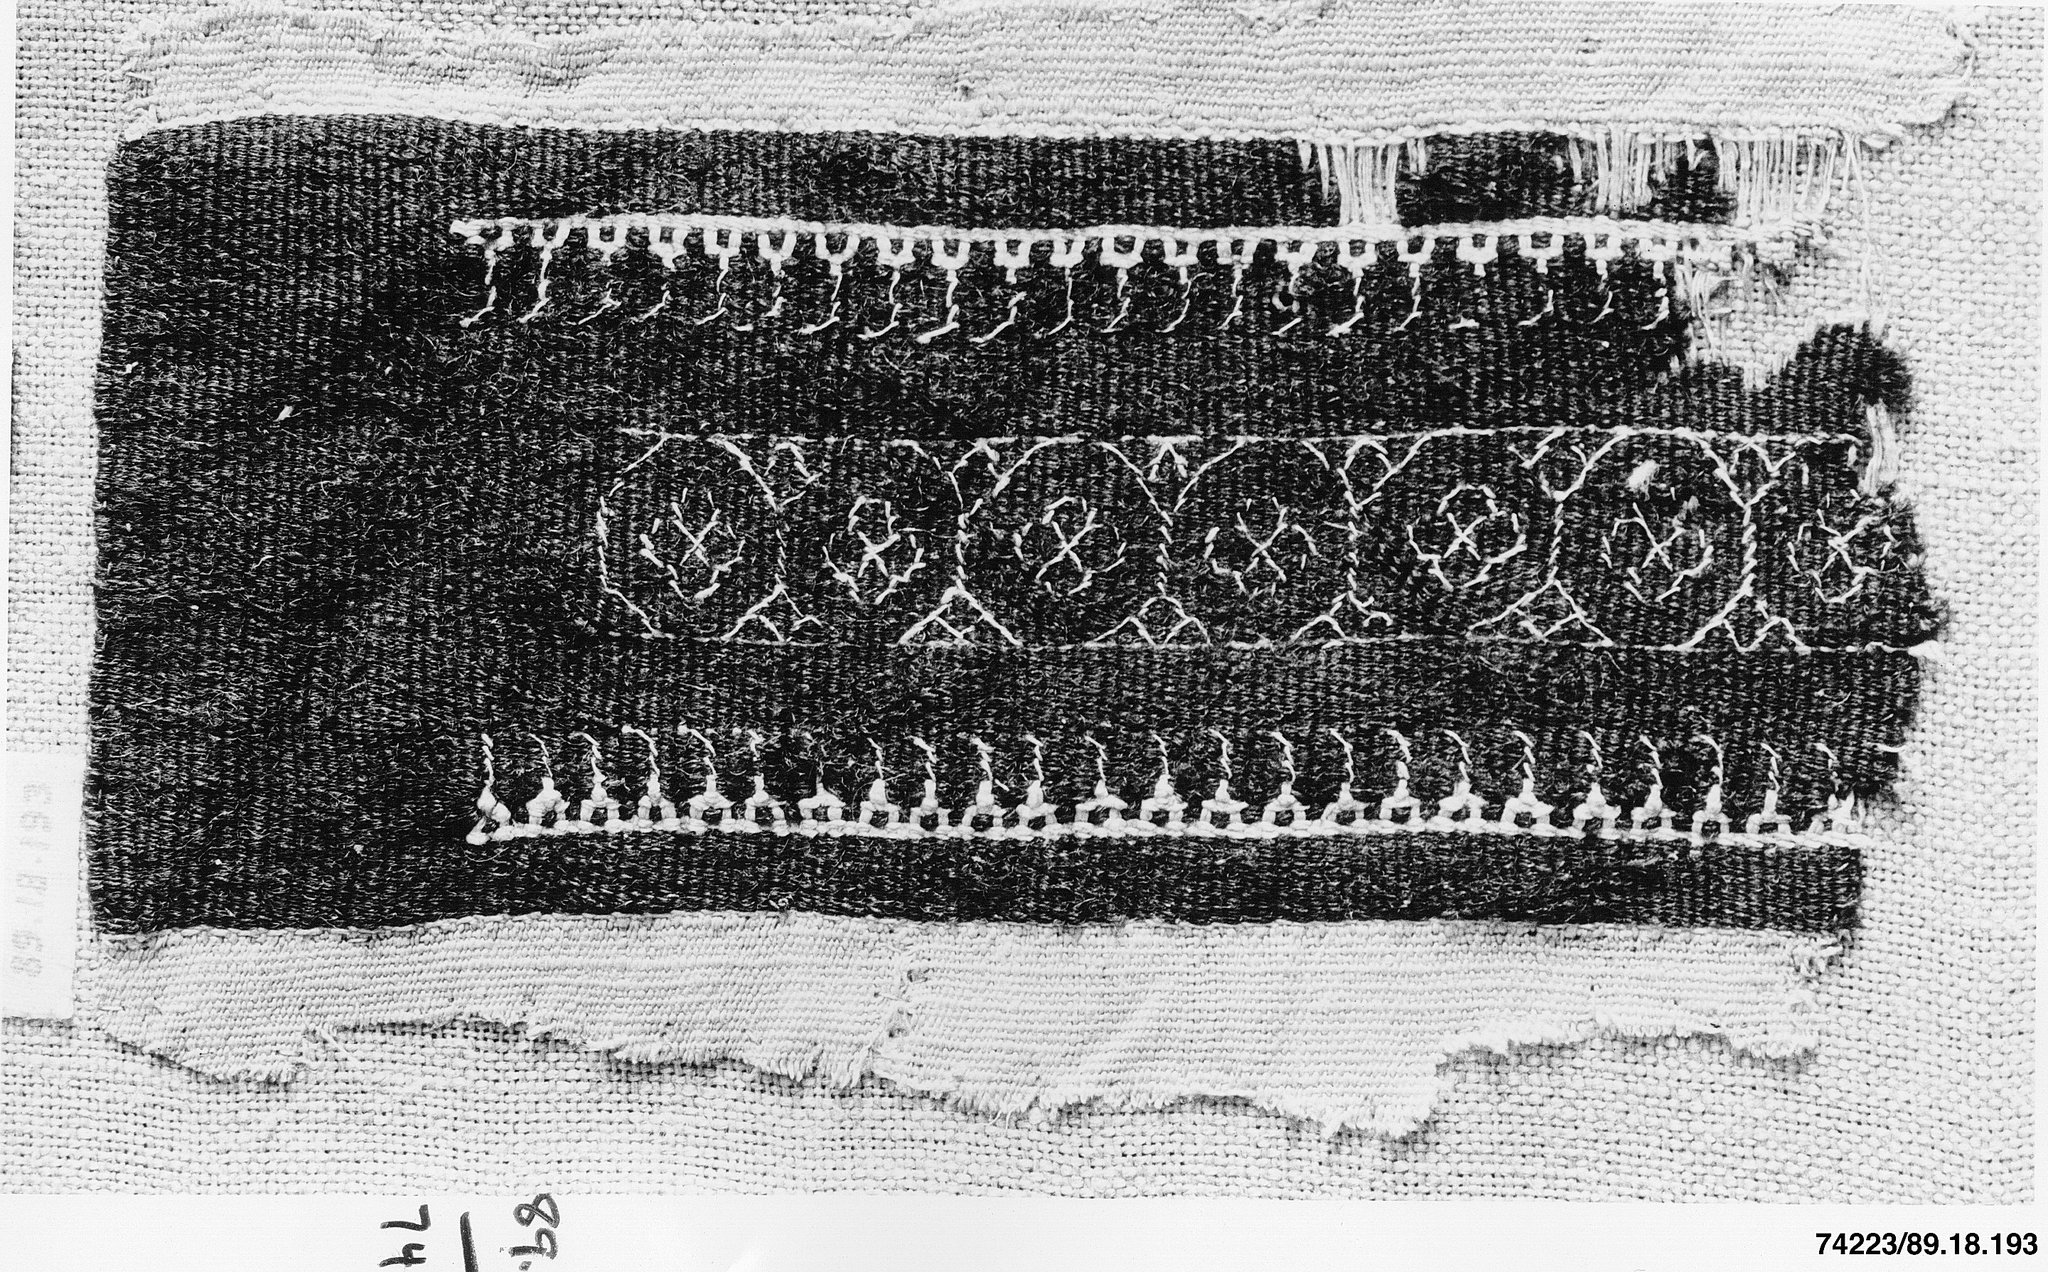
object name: textile fragment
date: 201-400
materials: linen, wool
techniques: weave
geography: egypt